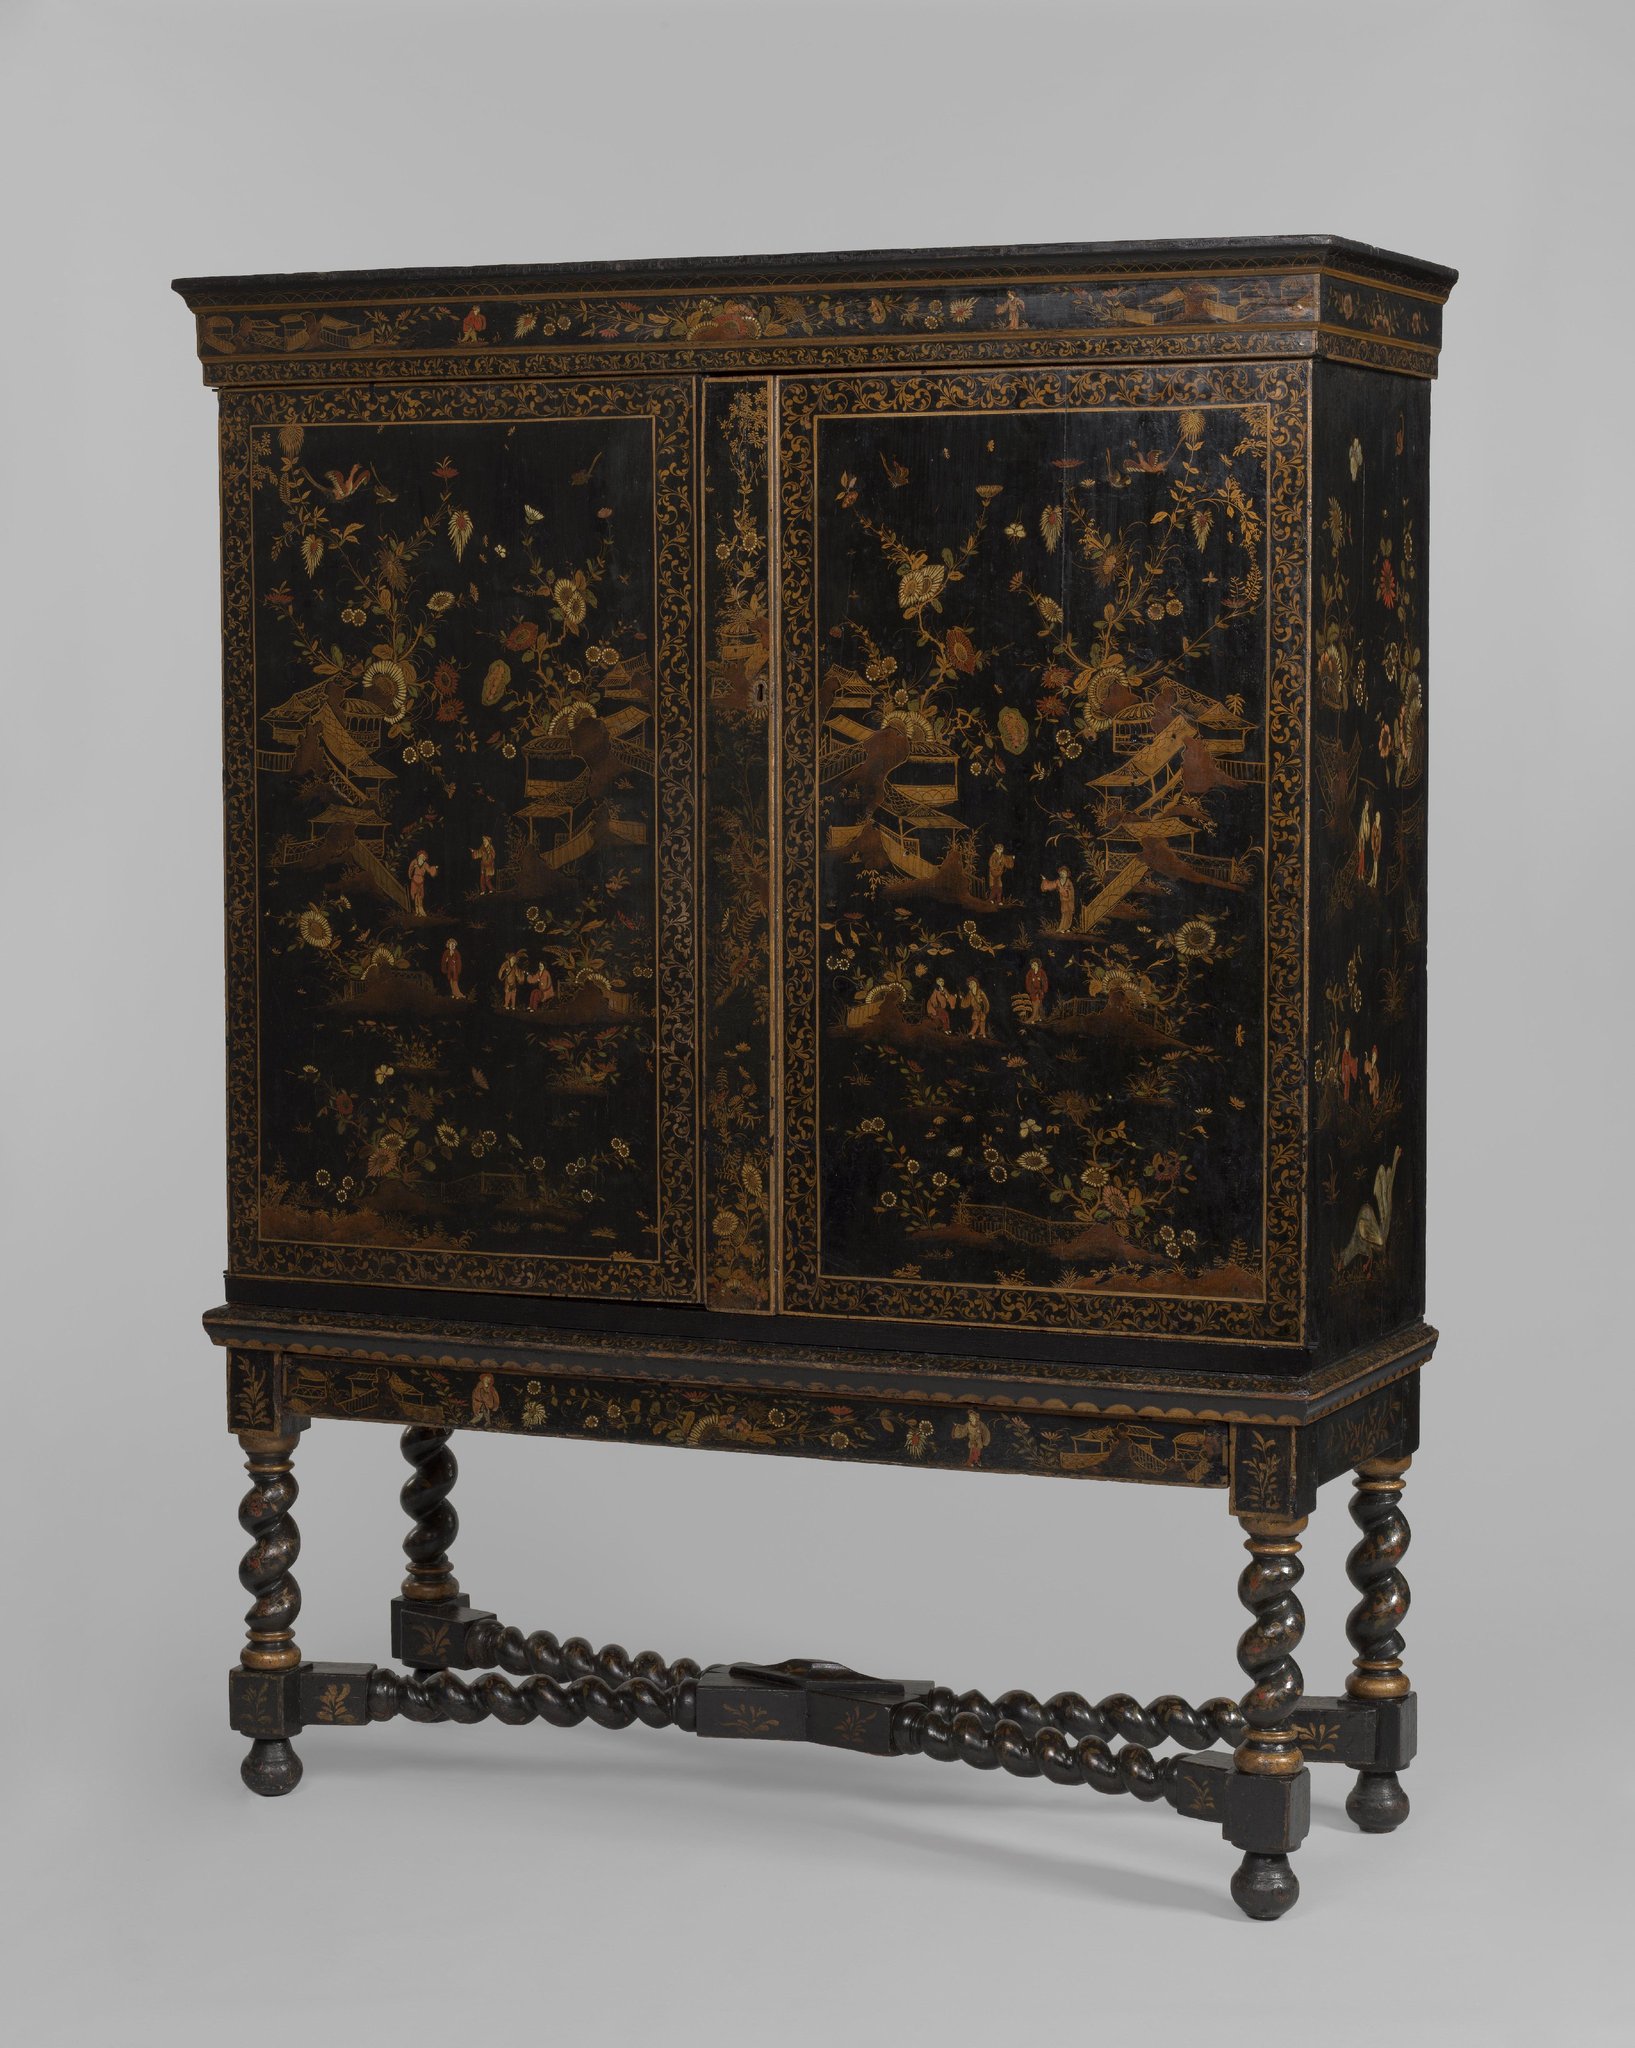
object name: kruisvoetkabinet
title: Cabinet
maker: Anonymous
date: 1670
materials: wood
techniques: lacquer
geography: netherlands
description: The decoration of the cabinet is based on lacquer work from China and Japan. Japanese lacquer was being imported into the Netherlands from the beginning of the 17th century onwards. Almost immediately, craftsmen in Amsterdam and other cities began to imitate it, although the materials to make true lacquer were lacking. Curiously, the decoration of the two doors is symmetrical.